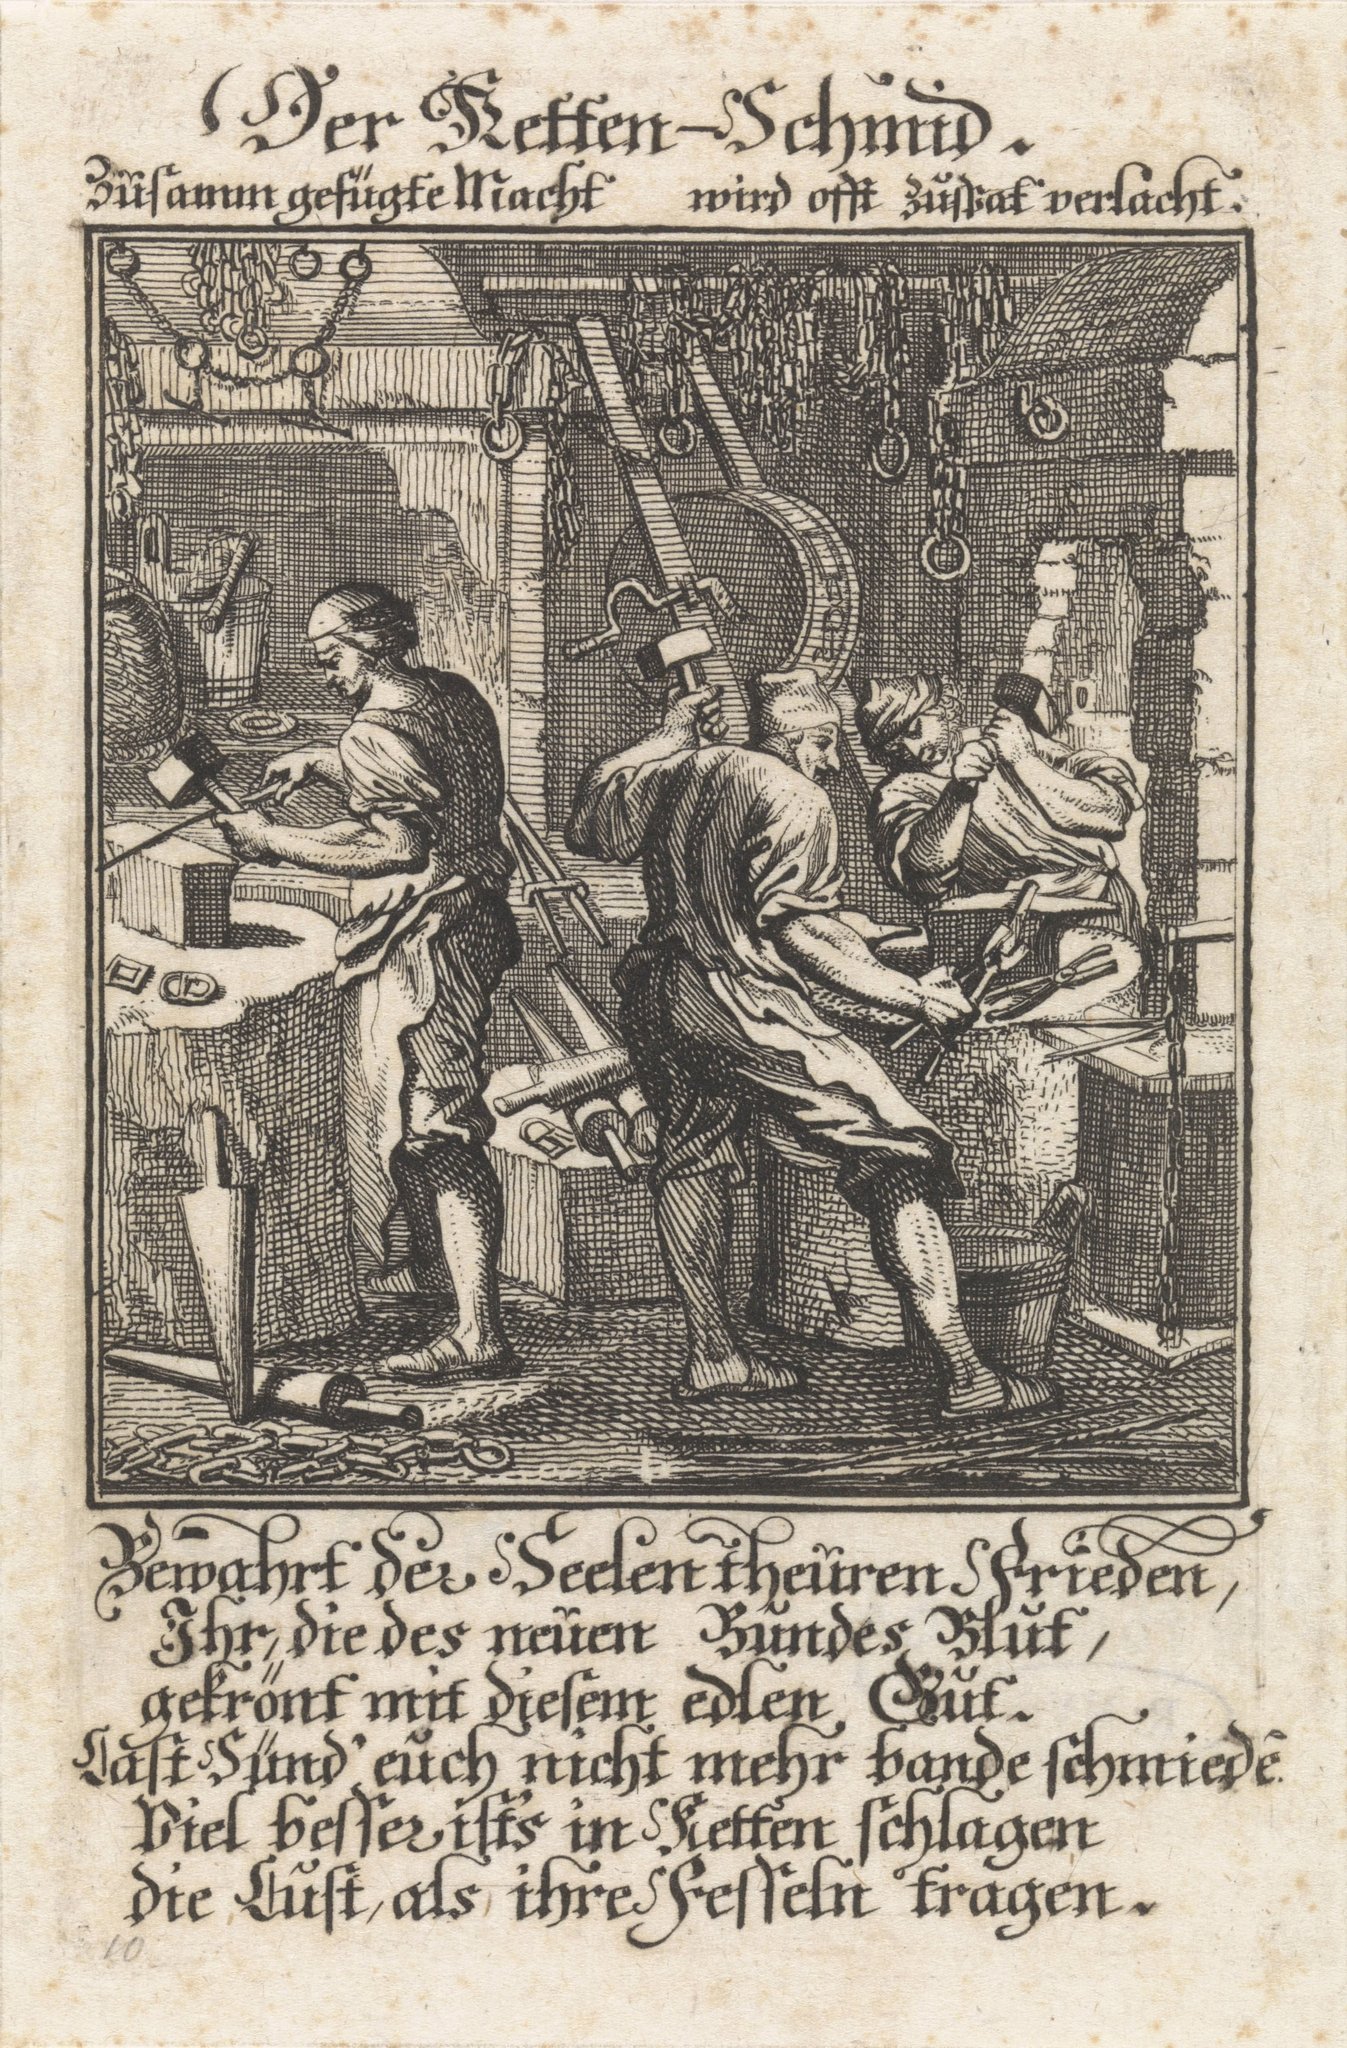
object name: book illustration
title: Kettingsmid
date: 1698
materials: paper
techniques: etching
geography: amsterdam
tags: smith, blacksmith, tools, aids, implements ~ crafts and industries: chain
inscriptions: collector's mark: Lugt 2228, number: ‘10’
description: Illustratie uit: Weigel, Christoff. Abbildung Der Gemein-Nützlichen Haupt-Stände Von denen Regenten Und ihren So in Friedens- als Kriegs-Zeiten zugeordneten Bedienten an, biß auf alle Künstler Und Handwercker. Regenspurg 1698, p. 386.